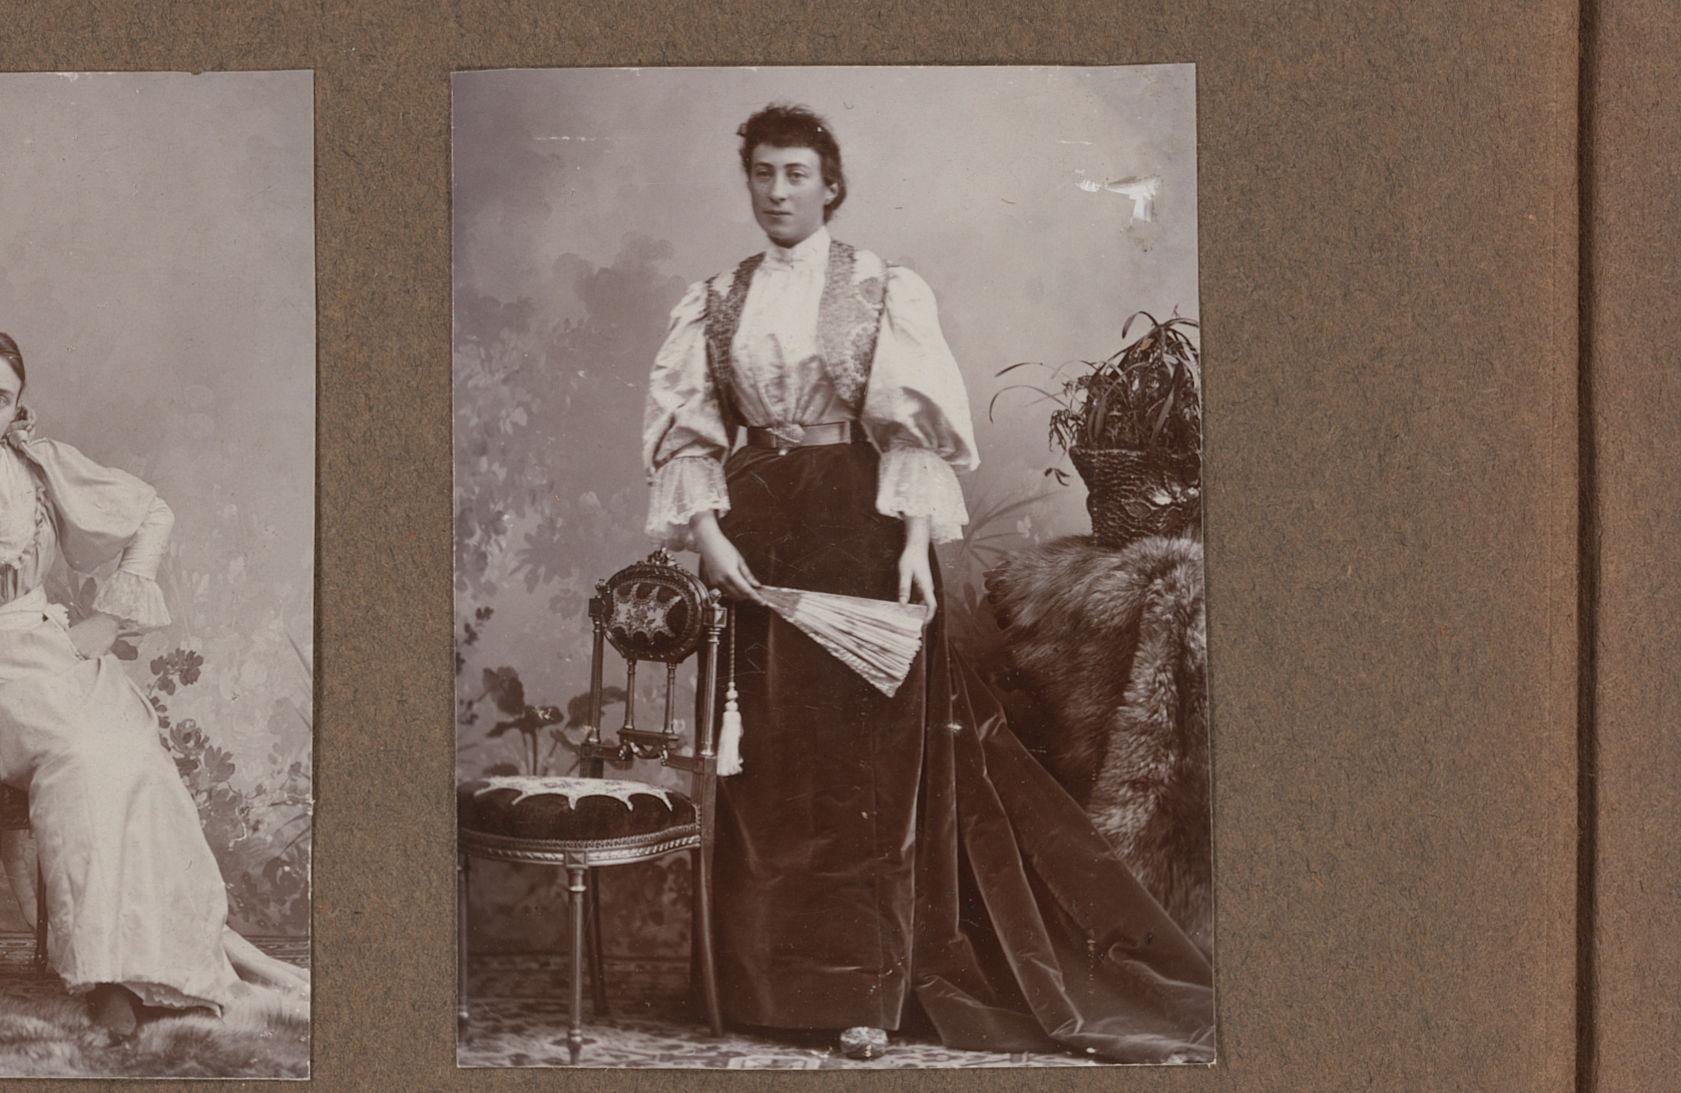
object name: photograph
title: Studioportret van staande vrouw met waaier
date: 1870-1920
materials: photographic support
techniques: photography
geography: amsterdam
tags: netherlands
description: Foto op bruin albumblad 34 van familiealbum van Alphons Diepenbrock.